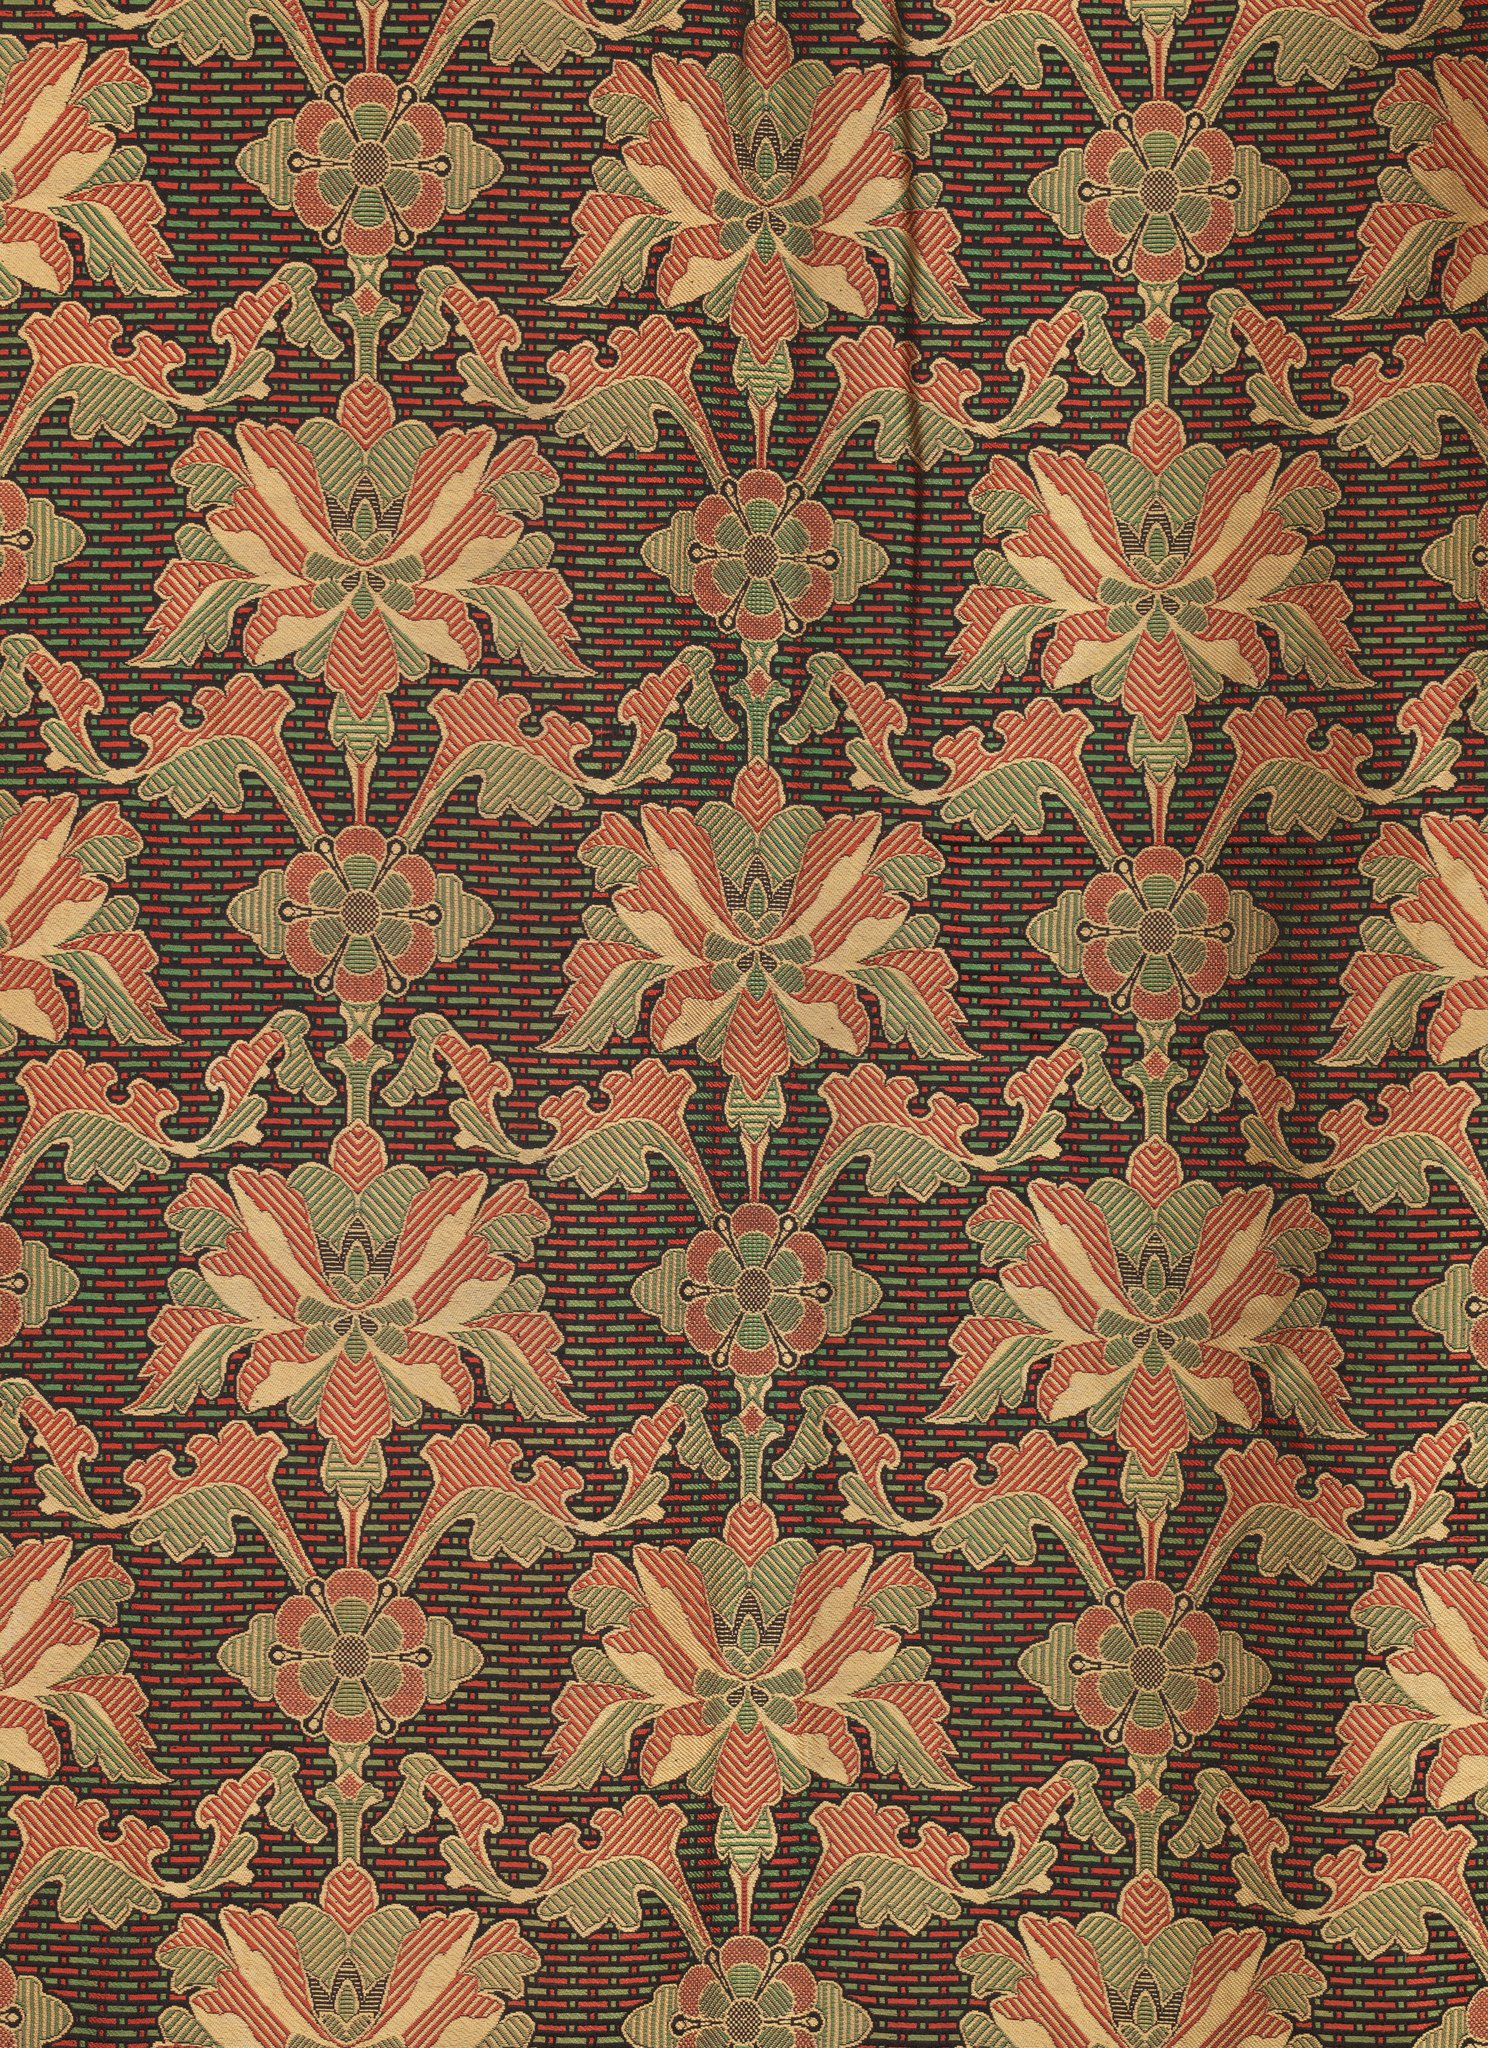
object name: curtain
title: Curtain of "Sultan" textile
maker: owen jones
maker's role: designer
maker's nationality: british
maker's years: 1809-1874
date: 1870-1874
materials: silk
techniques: jacquard, weave